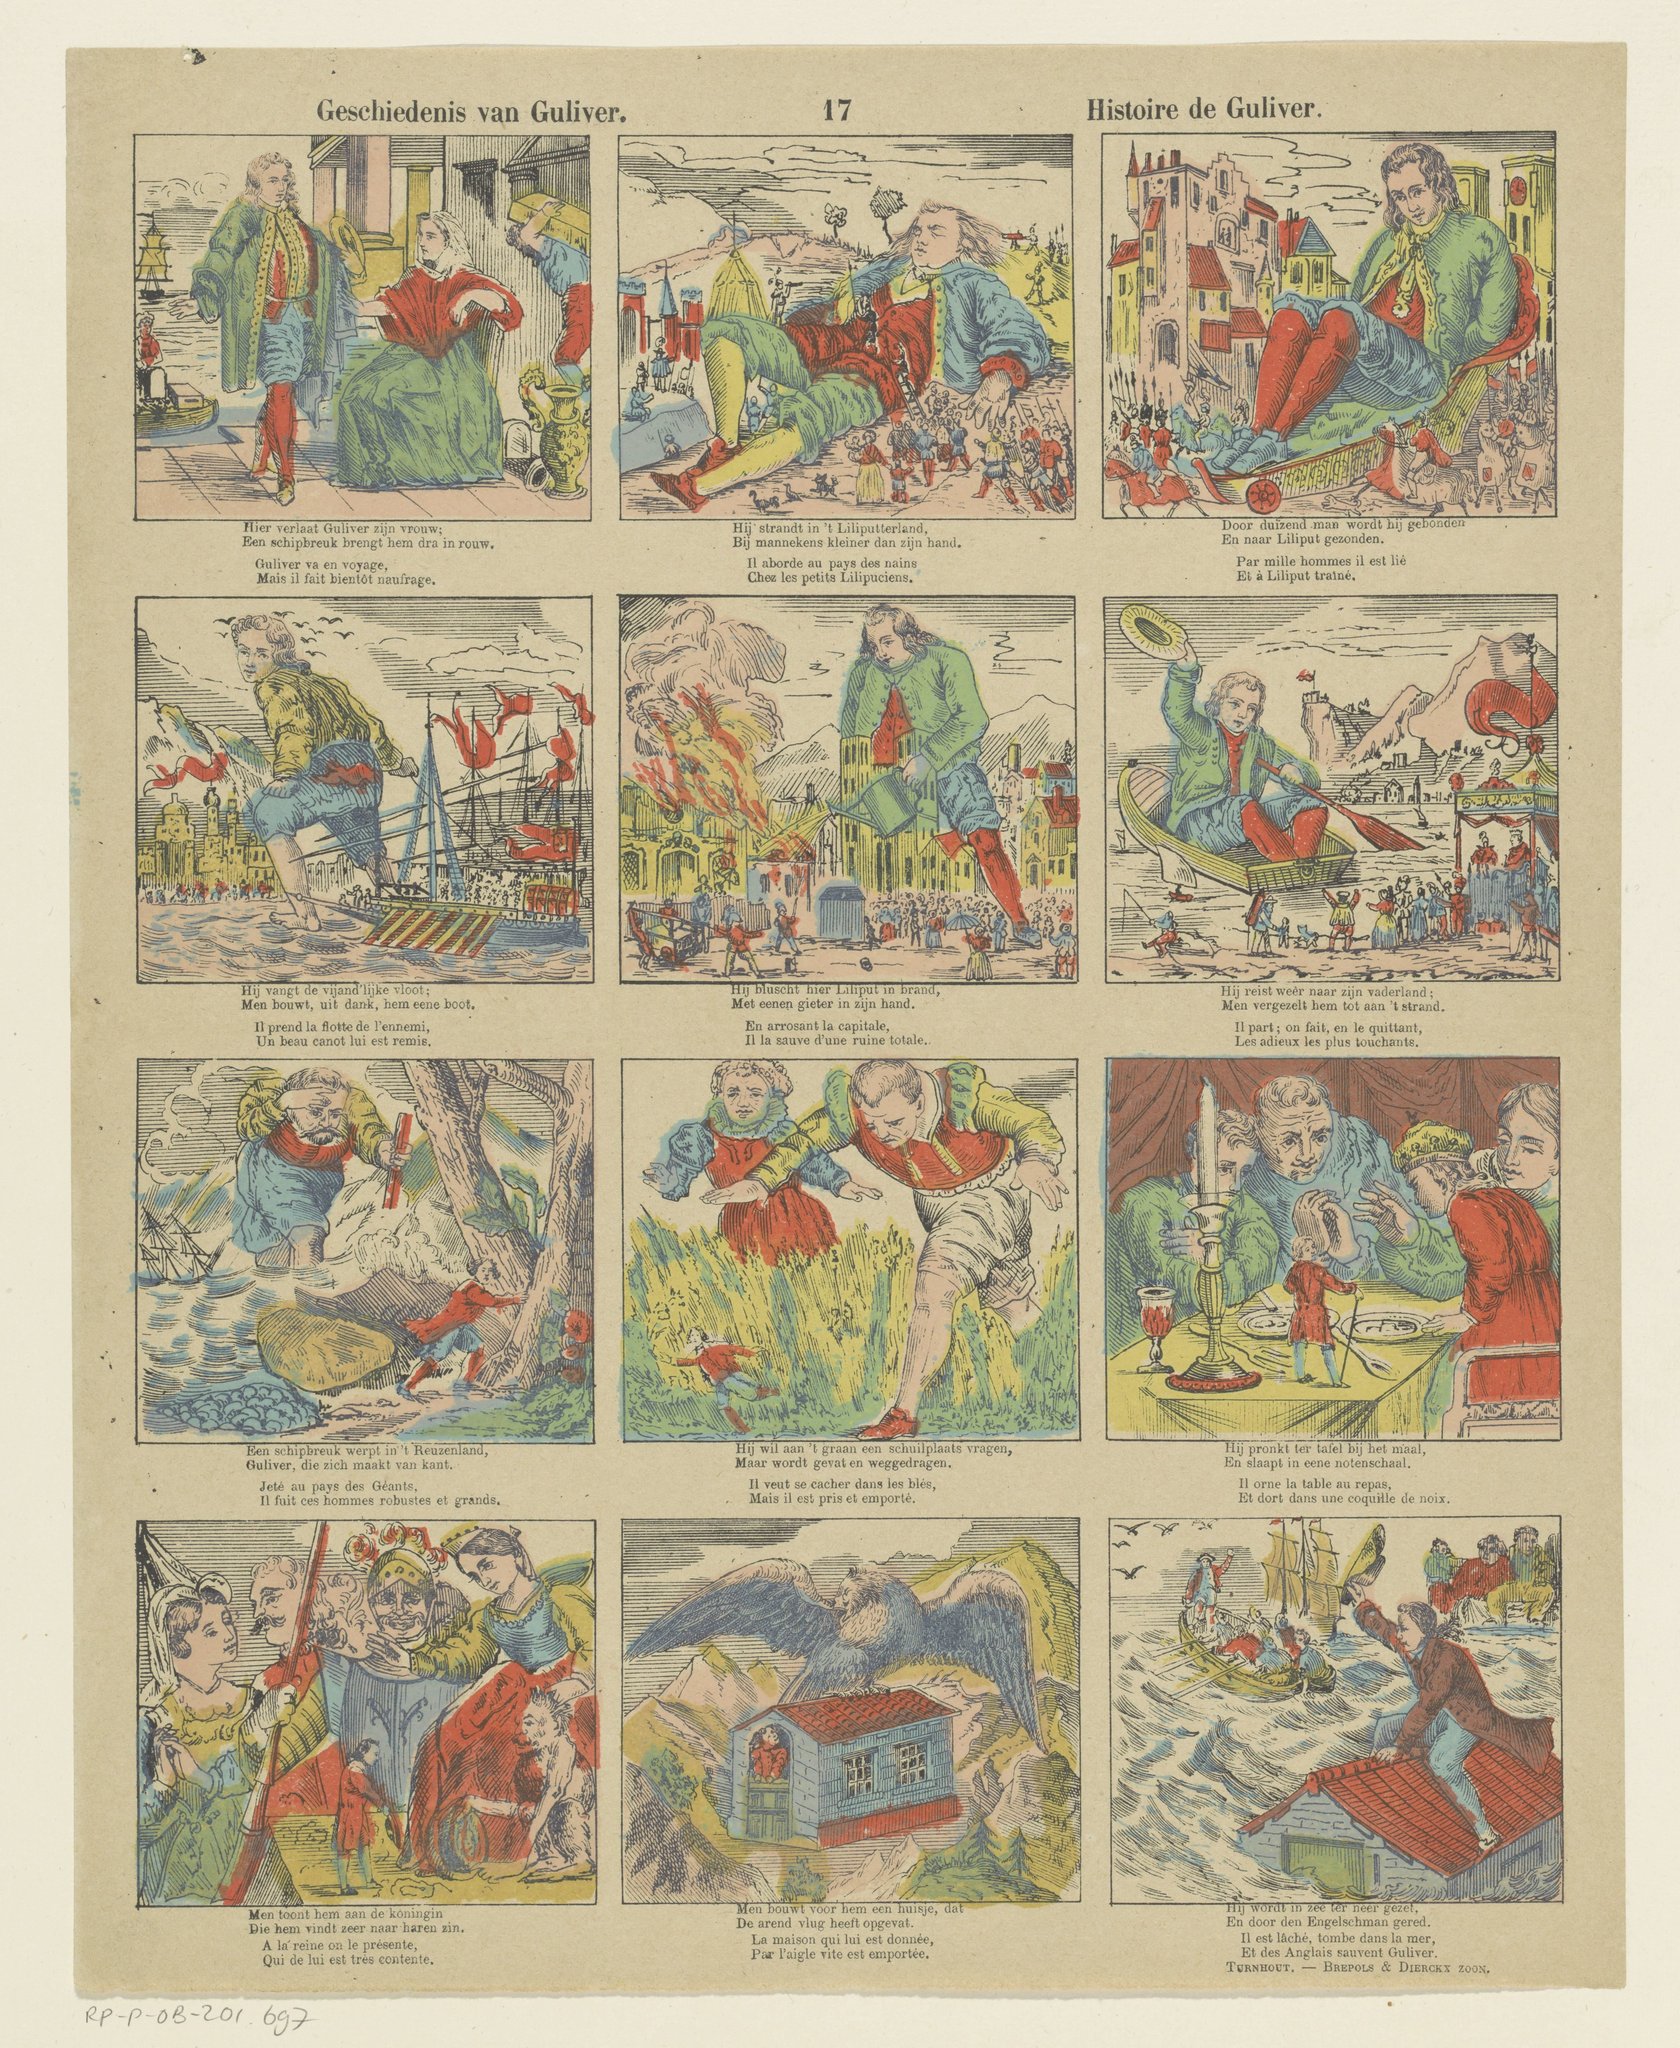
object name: popular print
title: Geschiedenis van Guliver / Histoire de Guliver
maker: Anonymous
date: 1833-1911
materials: paper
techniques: lithograph, letterpress printing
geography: turnhout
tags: (scenes from) specific works of literature: swift, gulliver's travels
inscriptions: collector's mark: Lugt 2760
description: Blad met 12 voorstellingen uit Gullivers reizen, waaronder Gulliver in Lilliput en twee reuzen die Gulliver gevangennemen. Onder elke voorstelling een tweeregelig vers in het Nederlands en het Frans. Genummerd midden boven: 17.